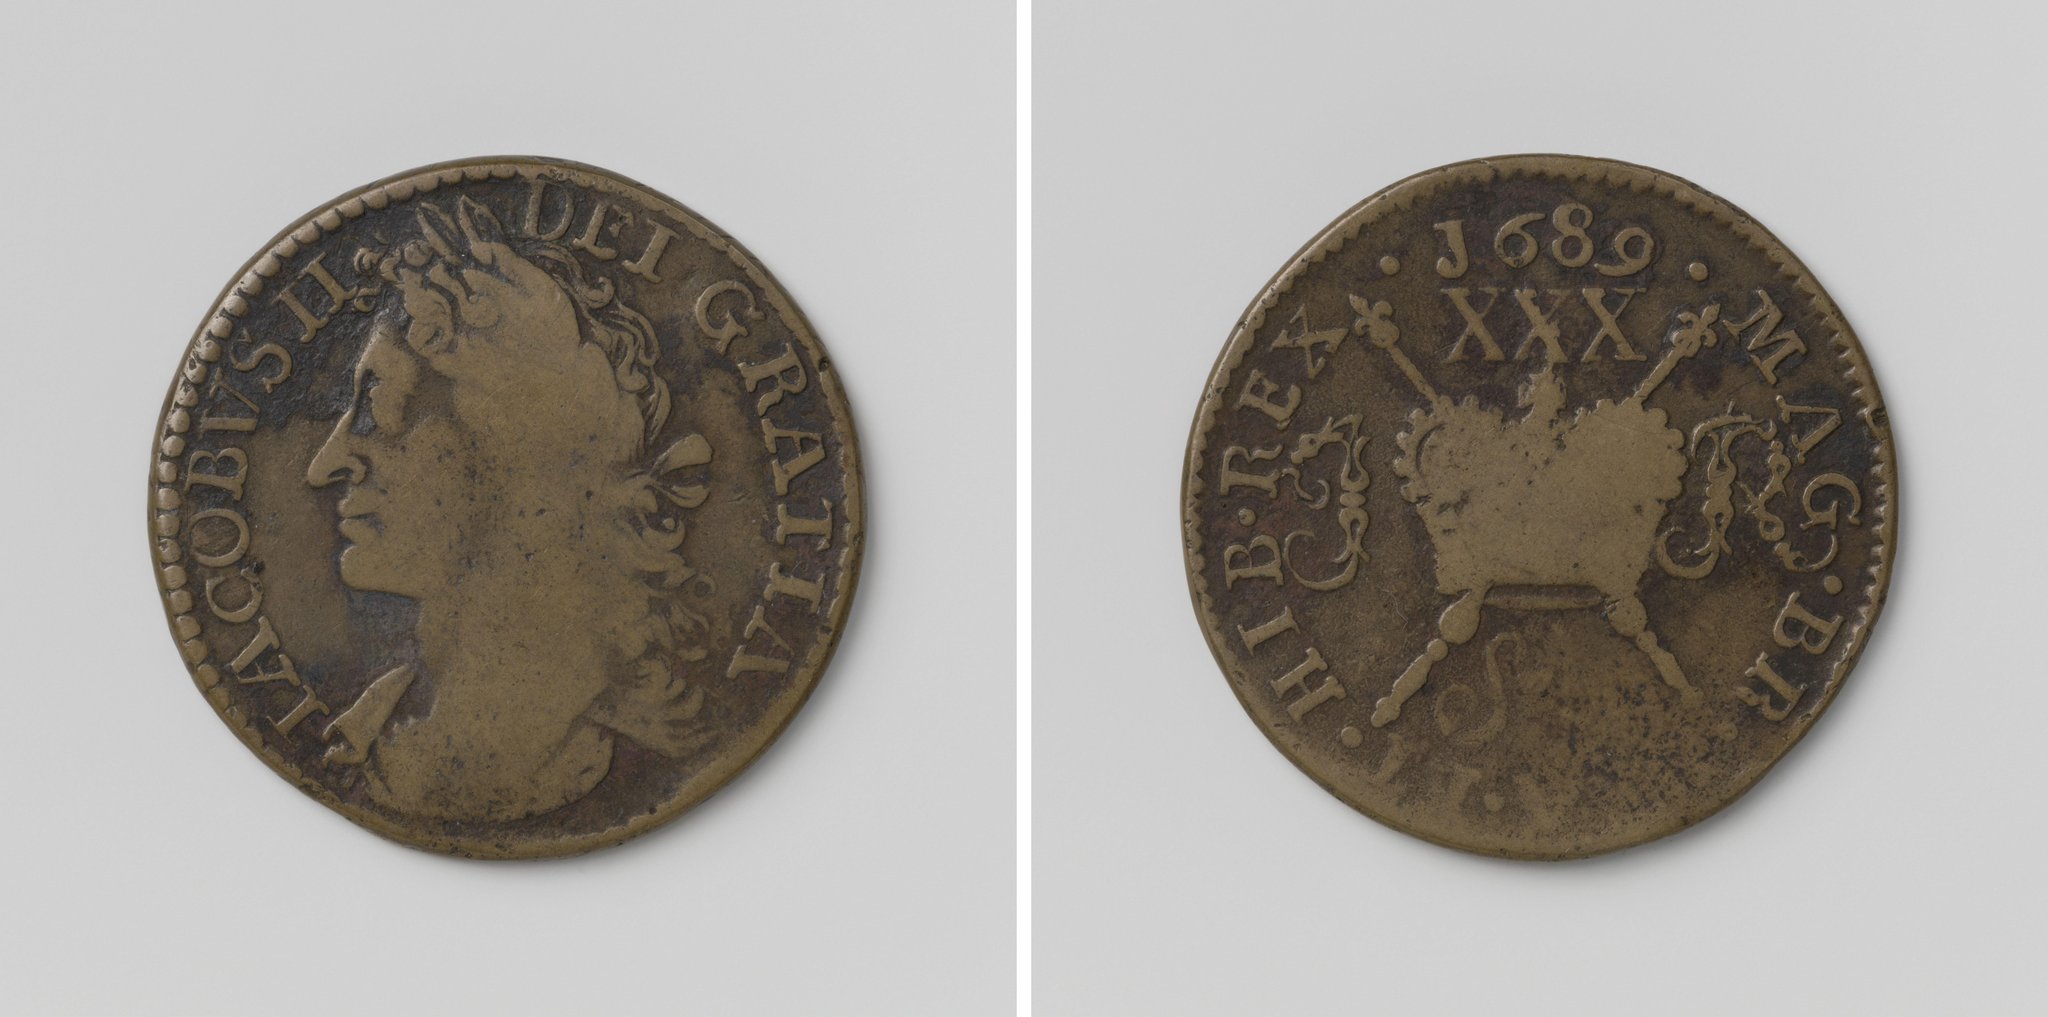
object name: coin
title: Halve crown, noodmunt van Jacobus II, koning van Engeland, uit september 1689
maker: Anonymous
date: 1609-1689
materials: copper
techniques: striking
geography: ireland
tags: jacobus ii (koning van engeland en schotland)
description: Voorzijde: borststuk man met lauwerkrans binnen omschrift. Keerzijde: kroon, waardoor twee gekruiste scepters steken tussen monogram van letters J en R; boven kroon Romeinse cijfer XXX, onder kroon opschrift "Se.." binnen omschrift